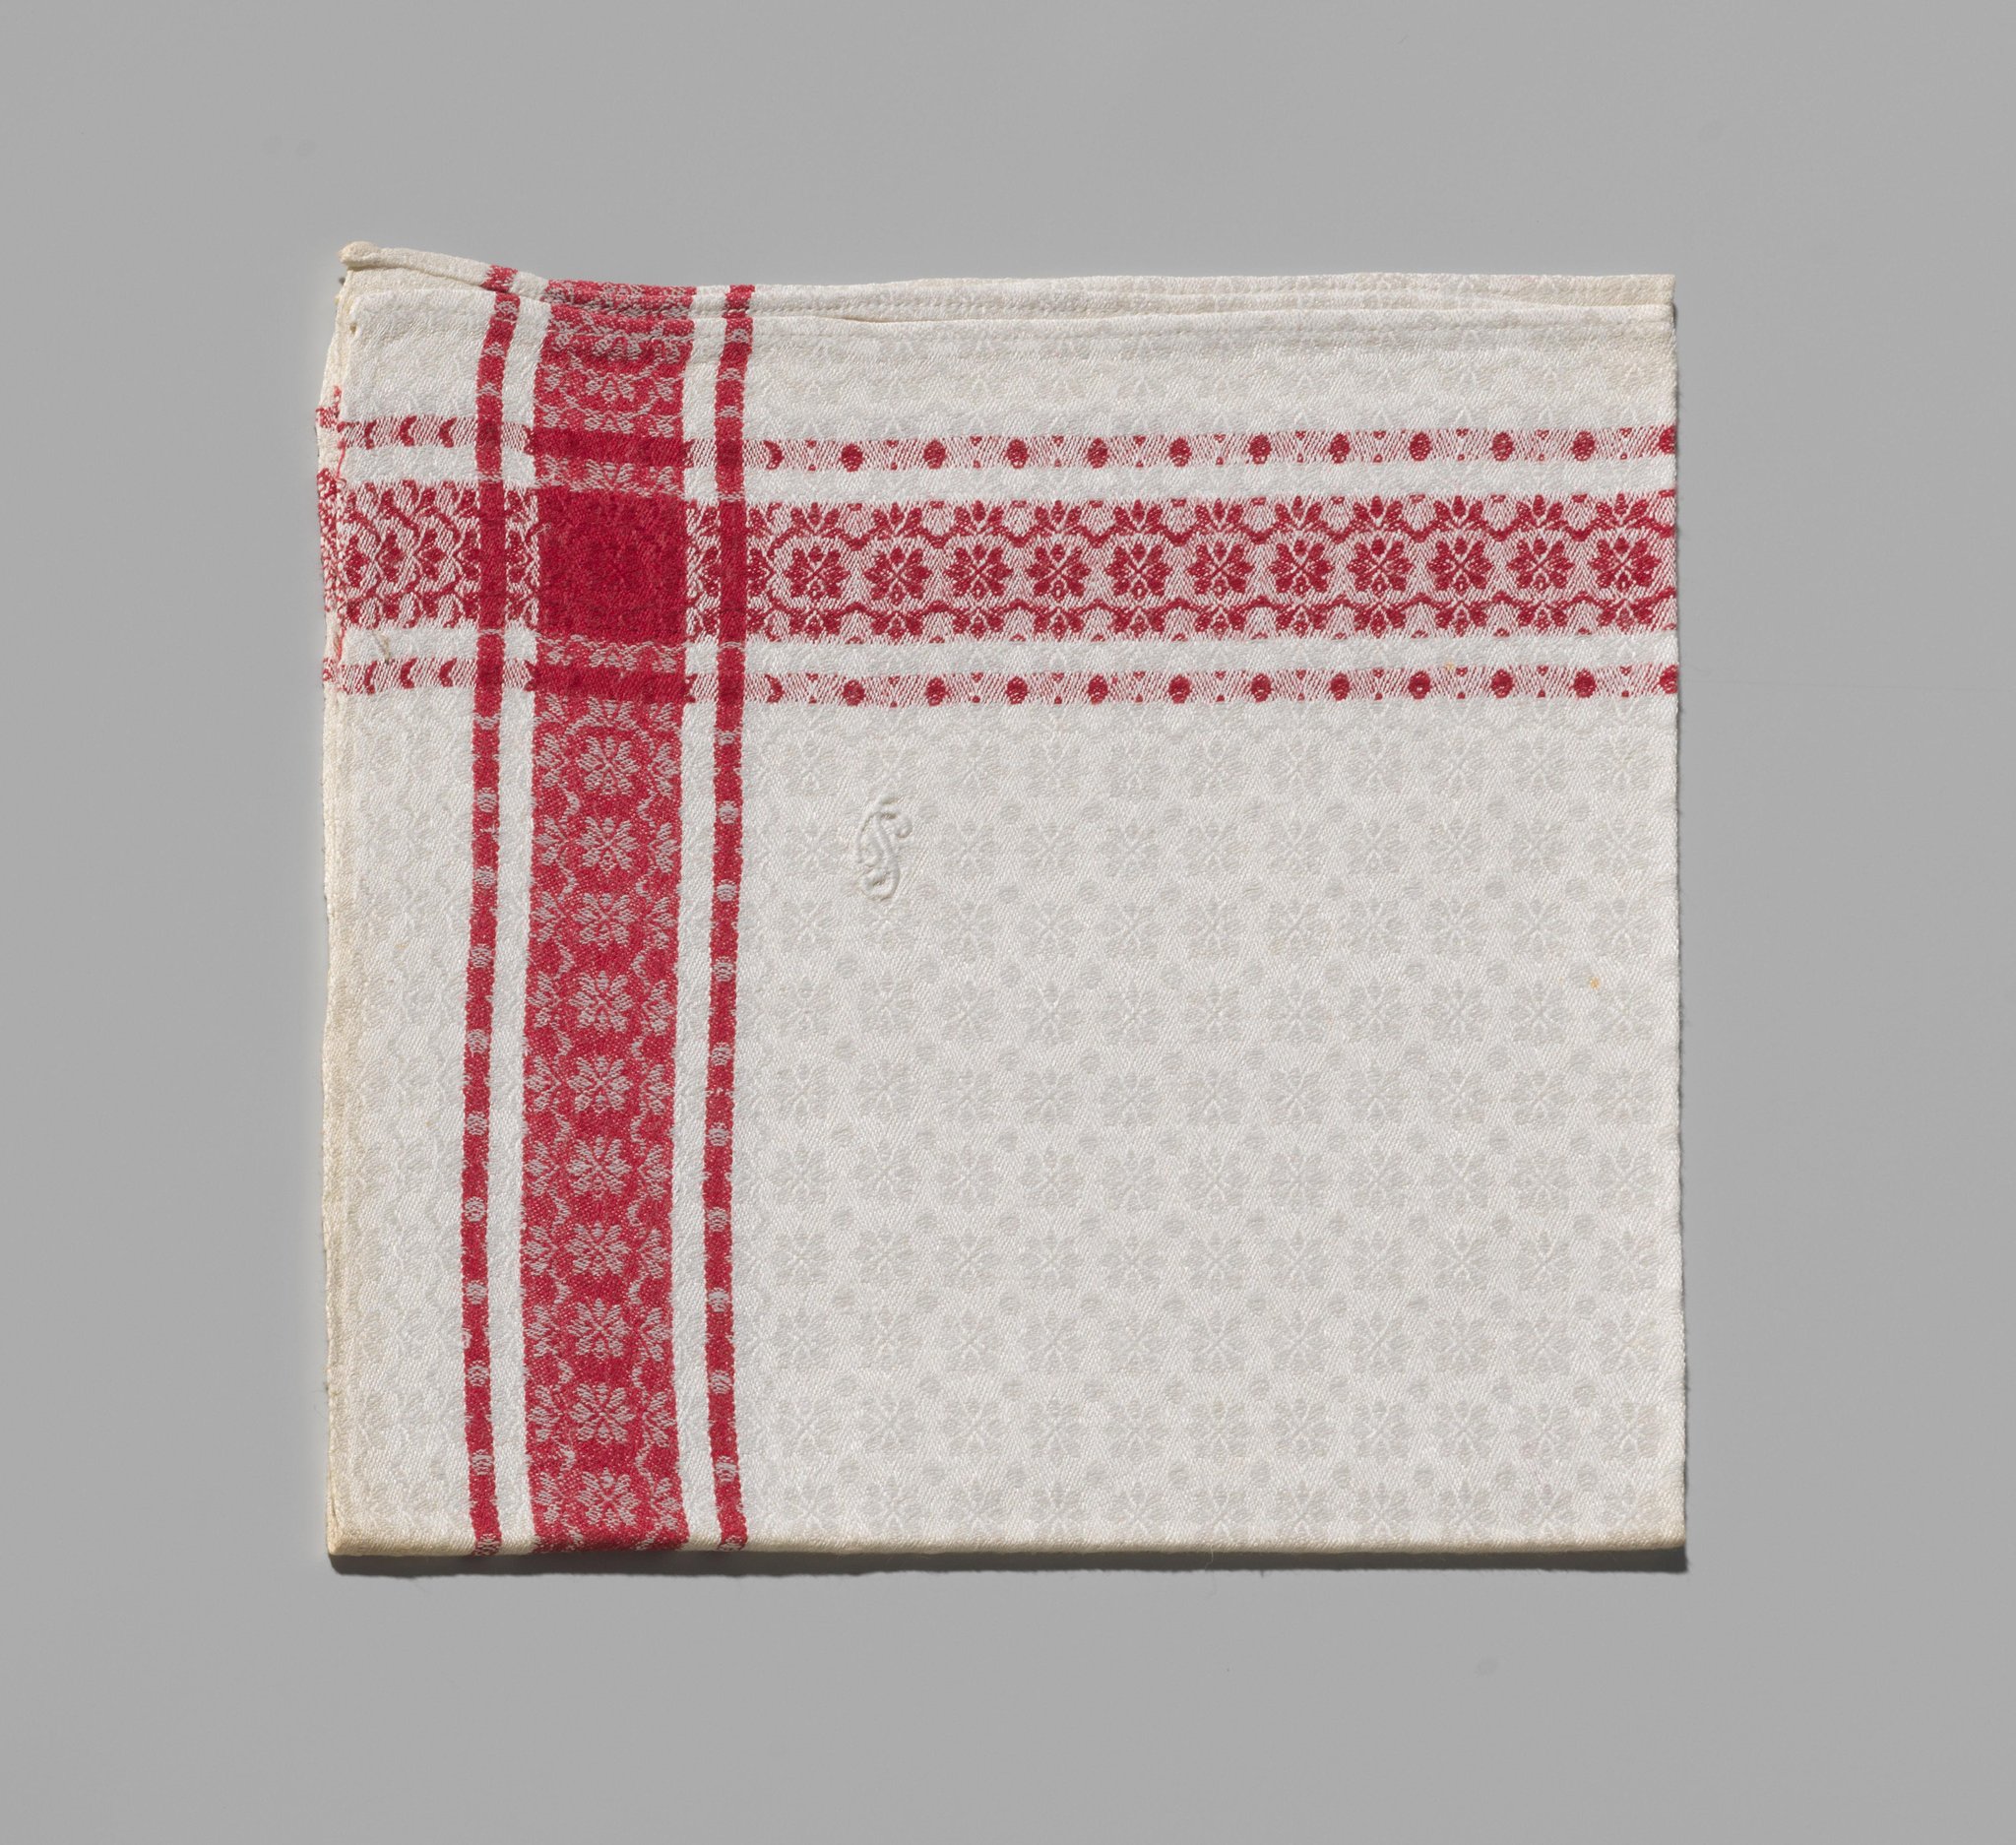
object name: vingerdoek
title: Vingerdoek van linnendamast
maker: Anonymous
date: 1900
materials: linen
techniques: damask, weave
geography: netherlands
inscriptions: monogram: ‘P’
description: Vingerdoek van linnendamast met rode ingeweven randen. Het patroon heeft sterren (of bloemen) en moesjes. De dubbele randen hebben sterren (of bloemen) en bladeren, geflankeerd door smalle randen met moesjes. In een hoek een in wit geborduurde letter P.